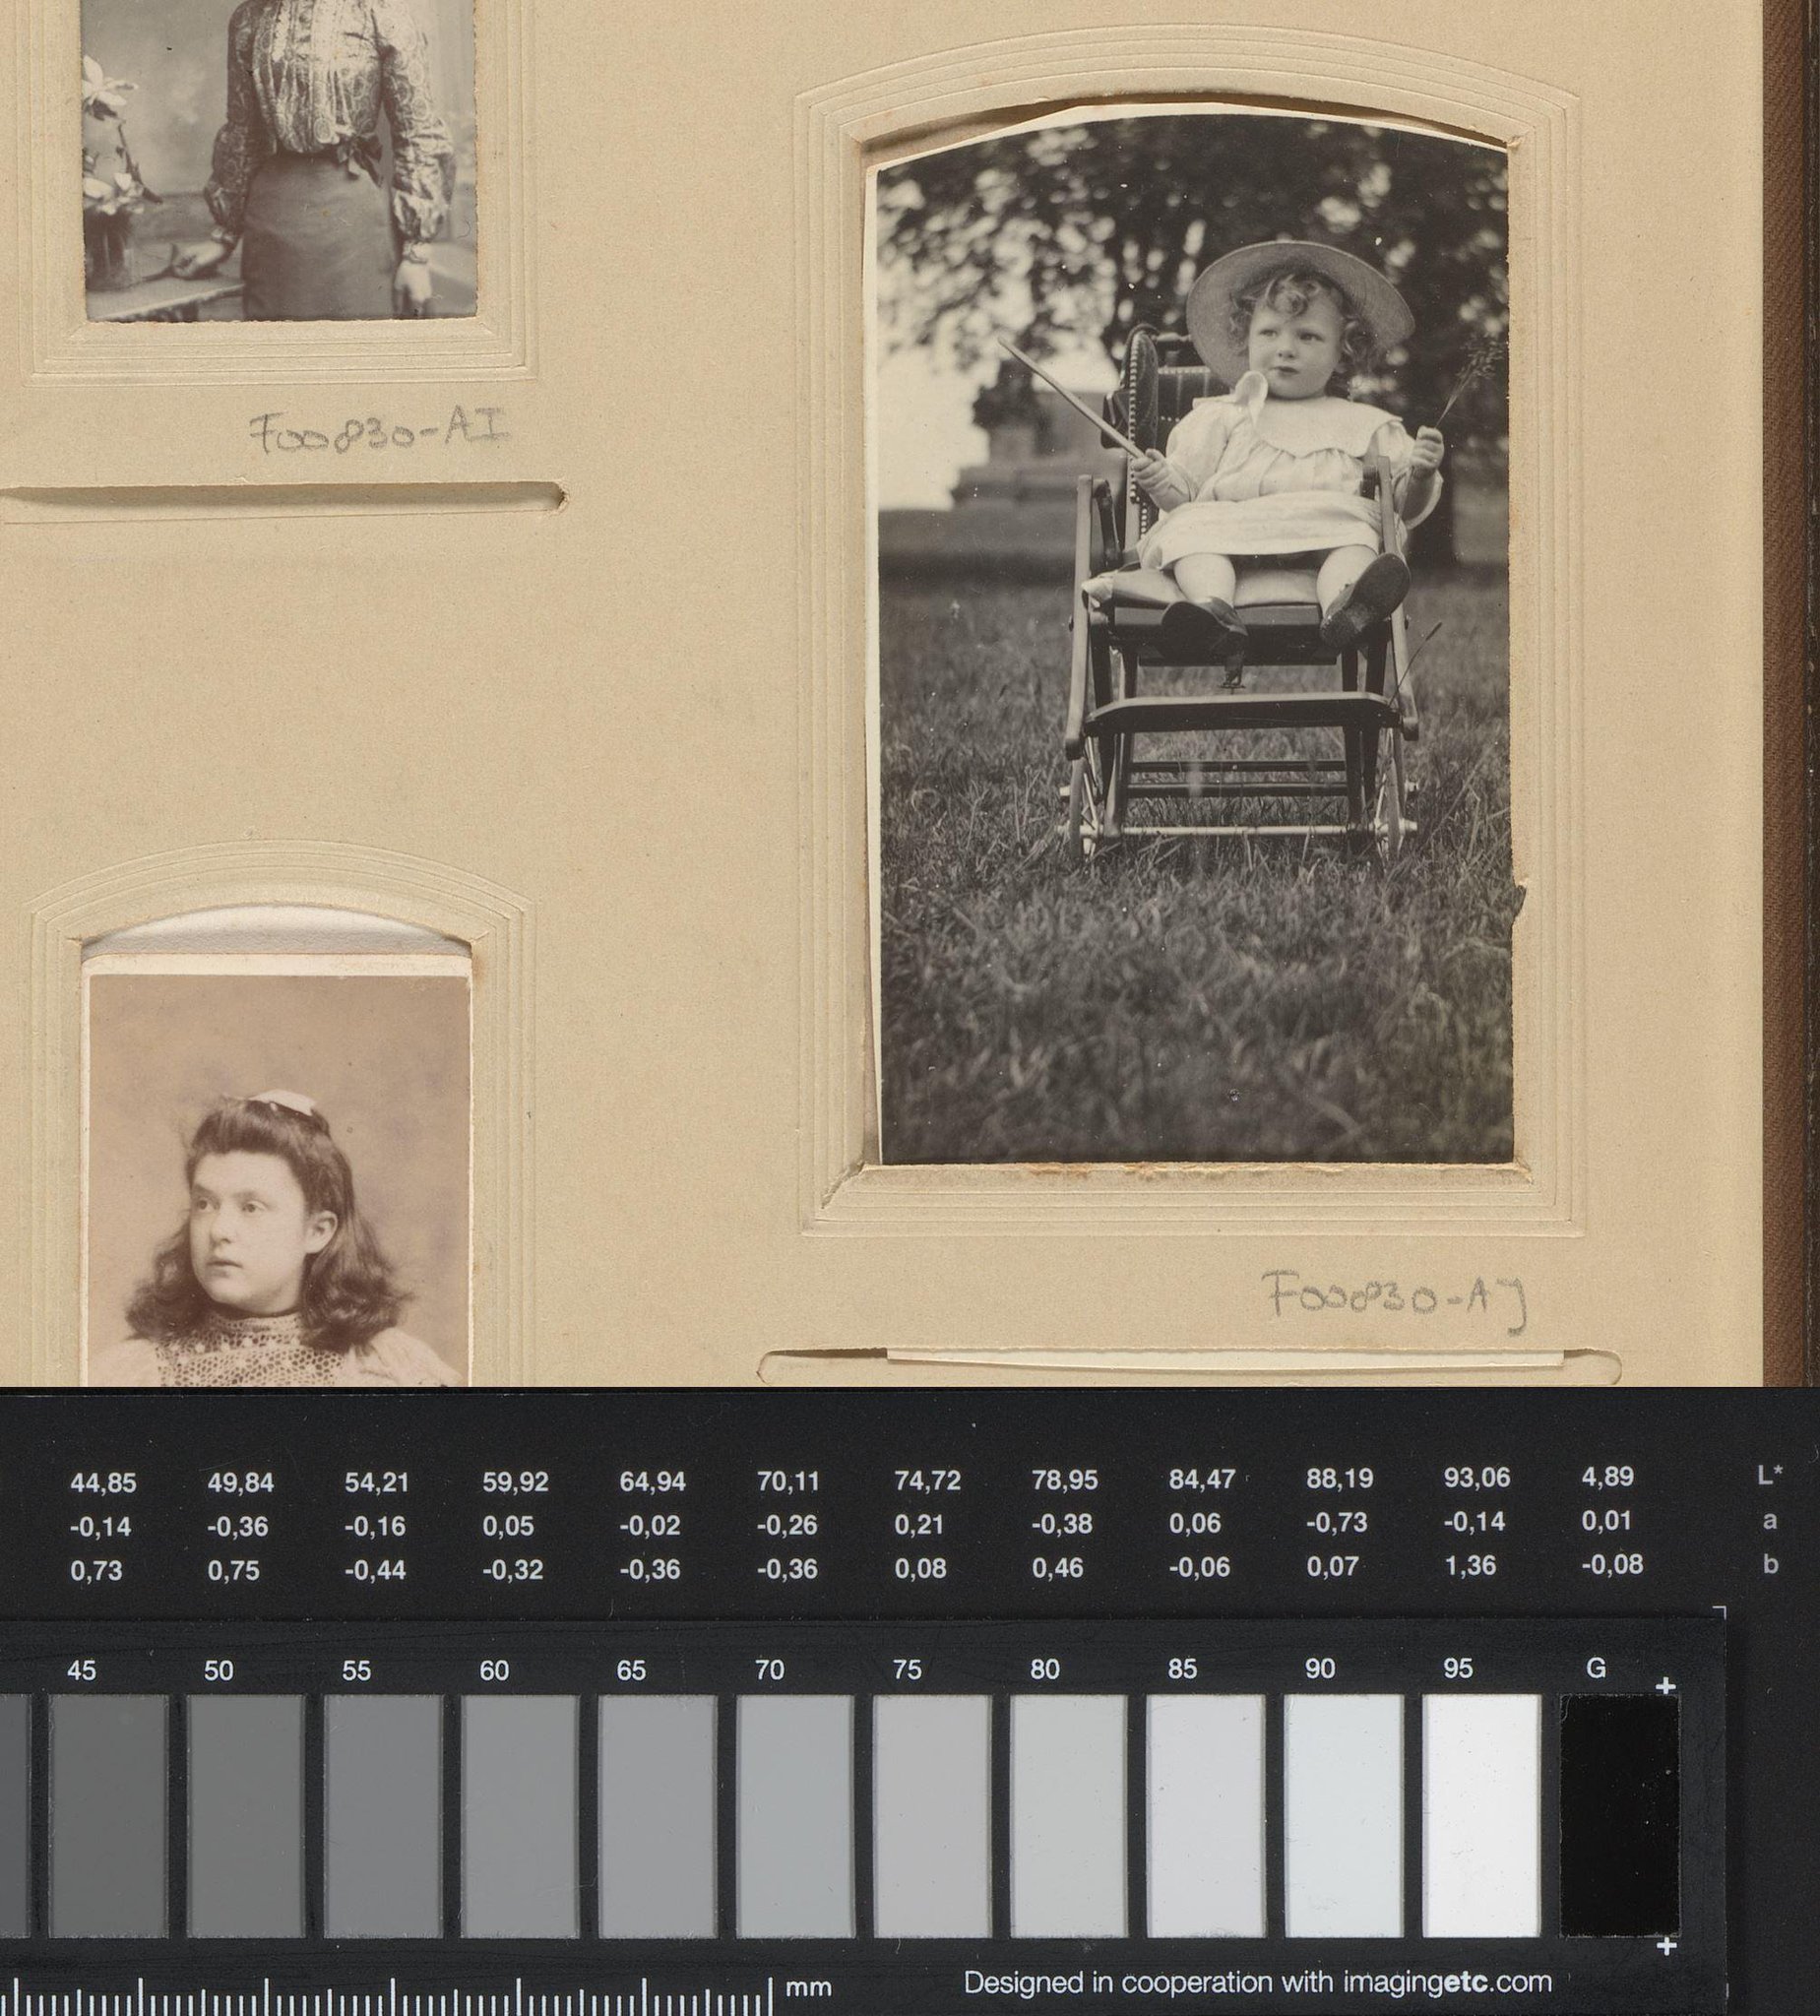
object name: album leaf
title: Portret van een kleuter in een kinderwagen in het gras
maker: Anonymous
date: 1890-1910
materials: cardboard, photographic support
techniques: gelatin silver print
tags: child, historical persons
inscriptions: annotation: ‘To dear [...]/ [...] best love from/ [...]’